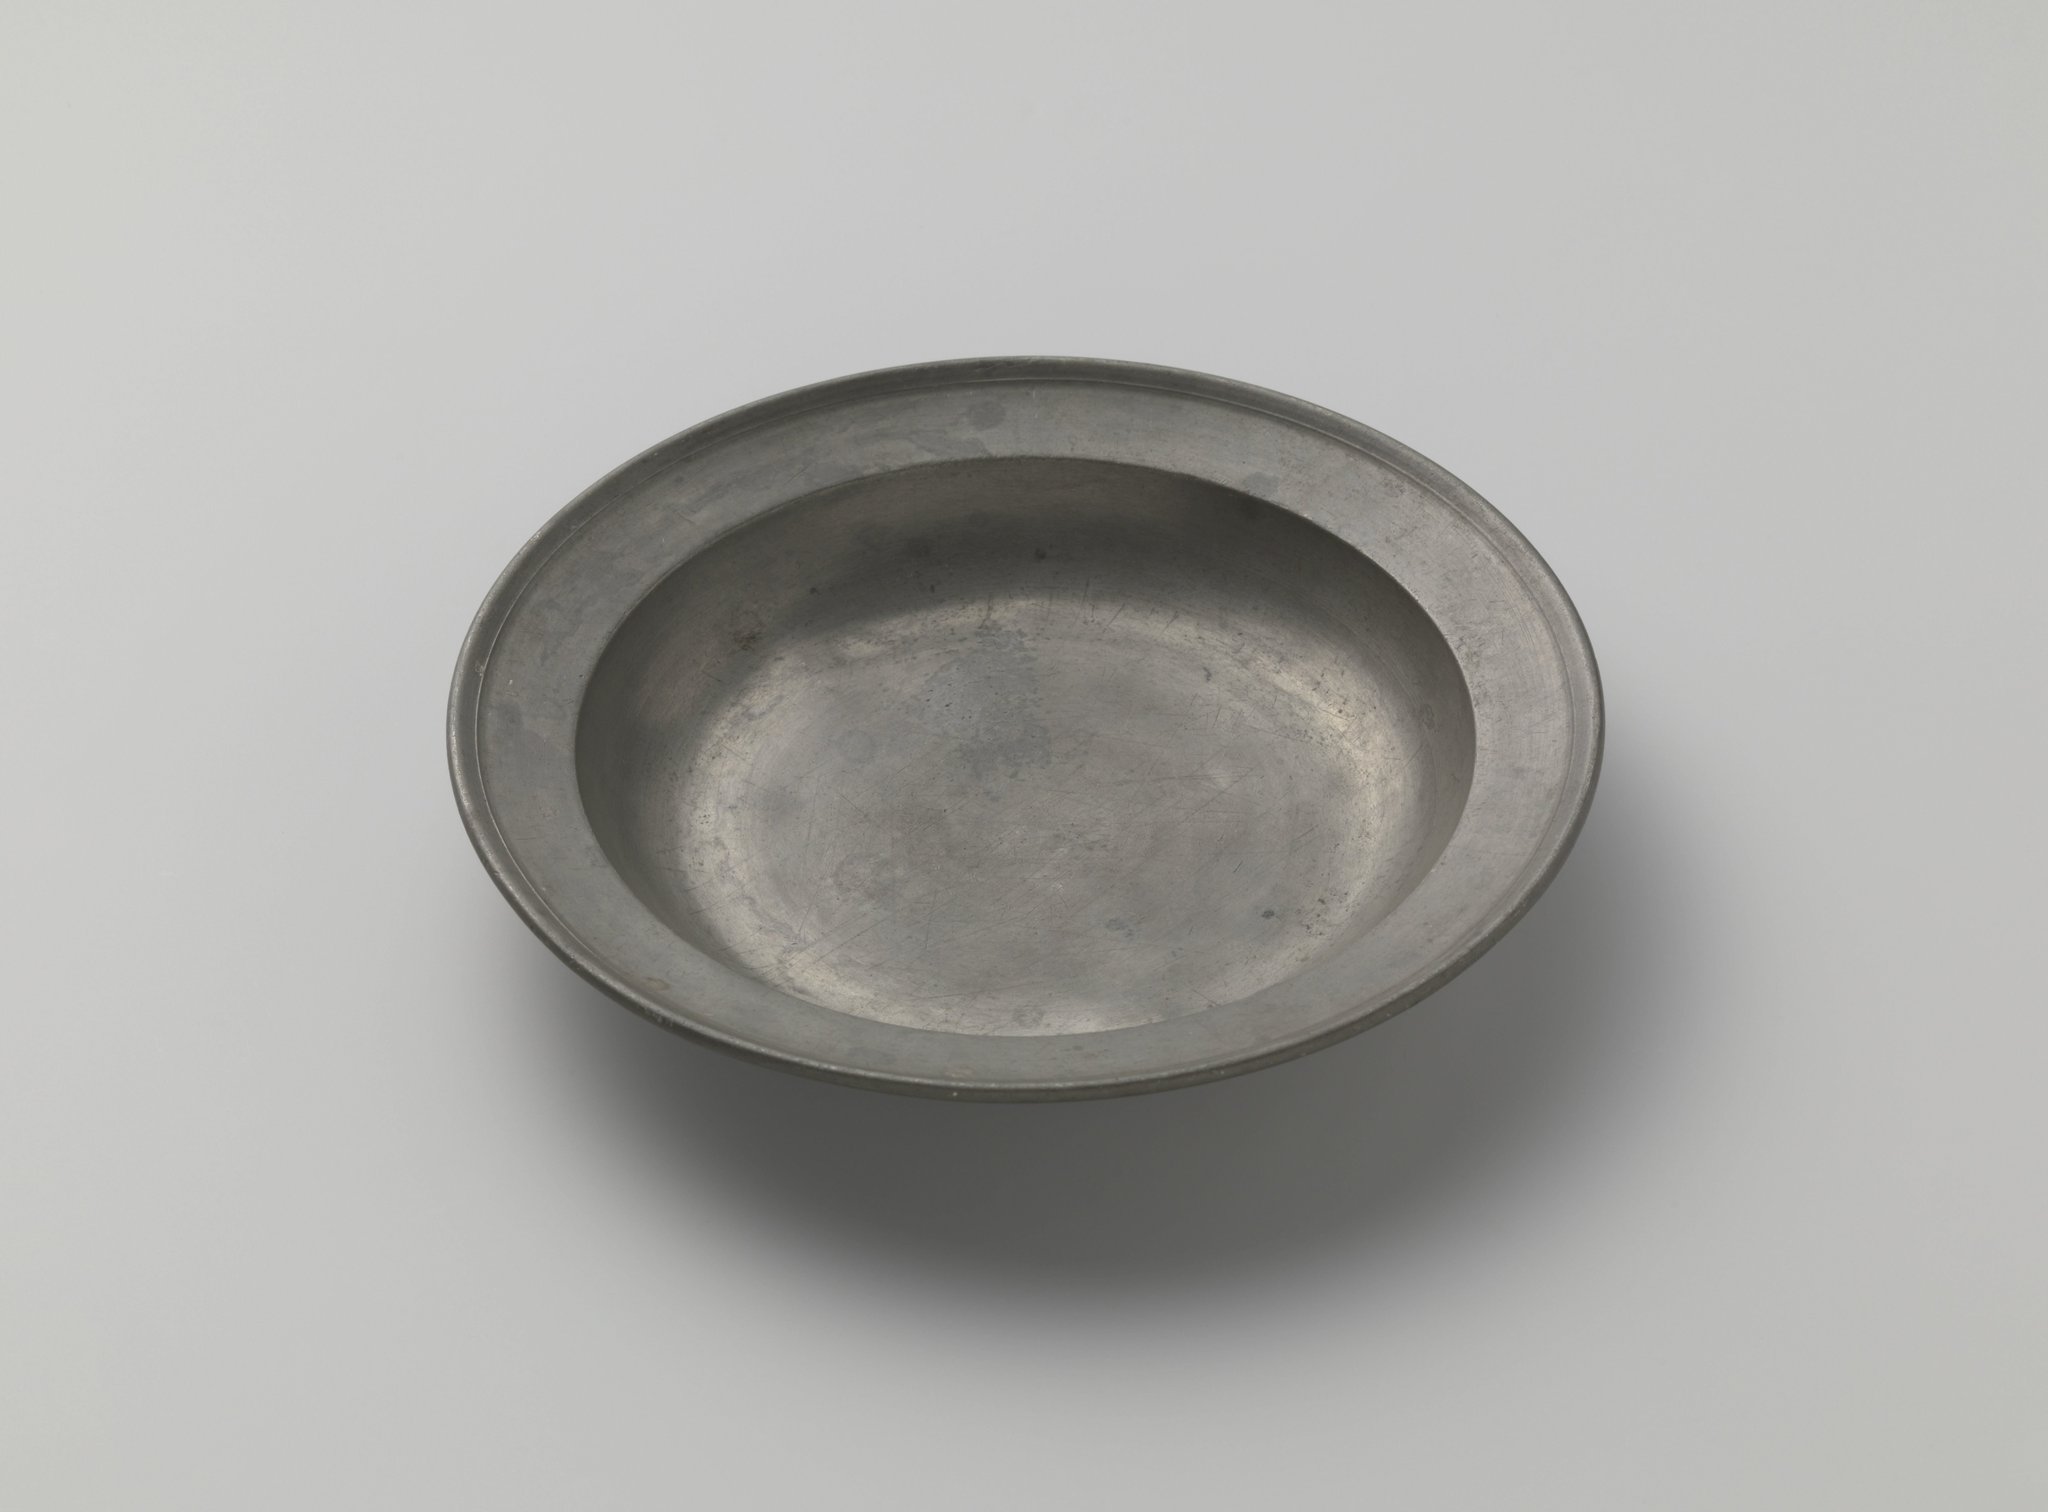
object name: plate dish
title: Rond bord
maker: Anonymous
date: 1700-1800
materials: tin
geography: low countries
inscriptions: quality mark, quality mark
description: Rond bord van tin. De dunne rand is omgeslagen.